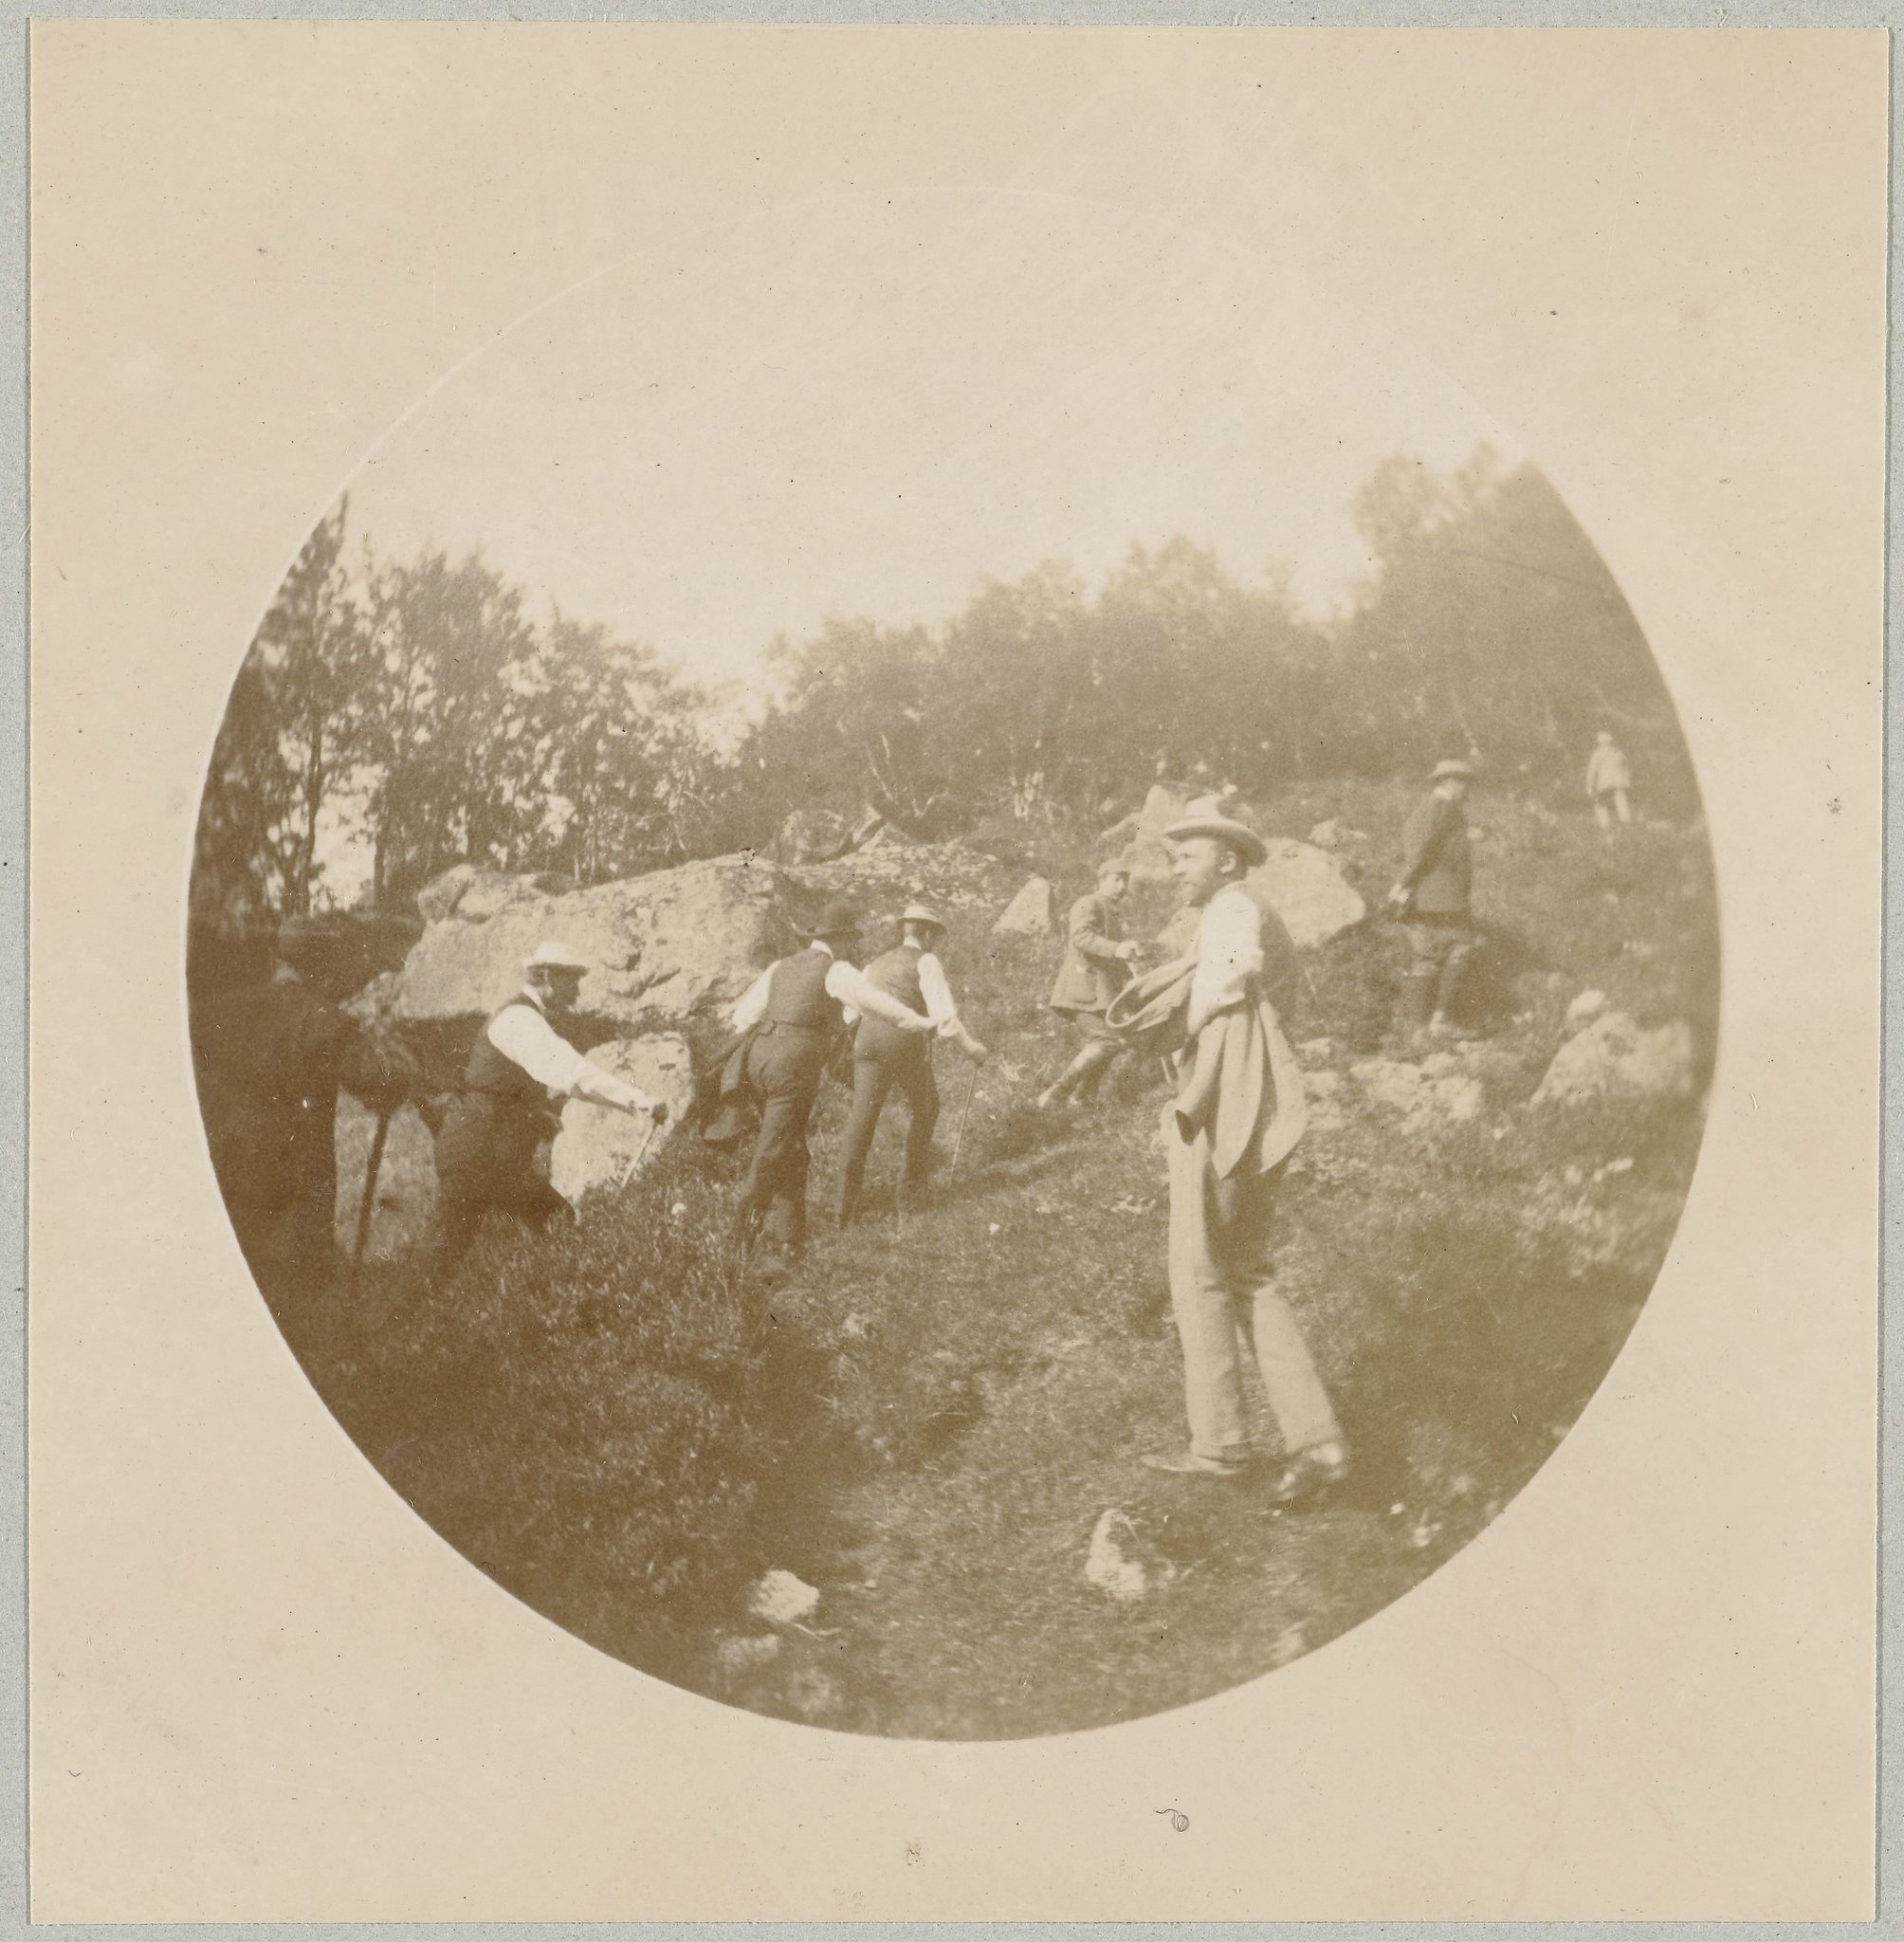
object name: photograph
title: In den Lofoten, Errichtung des Steinmanns auf dem Gipfel von Diggermulen und Heimkehr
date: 1807-1889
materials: cardboard, paper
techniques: gelatin silver print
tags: wilhelm ii (keizer van duitsland), norway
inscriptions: number: ‘33’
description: De afdruk van de foto is rond, het papier vierkant. foto gemaakt met Nr. 1 Kodak Camera